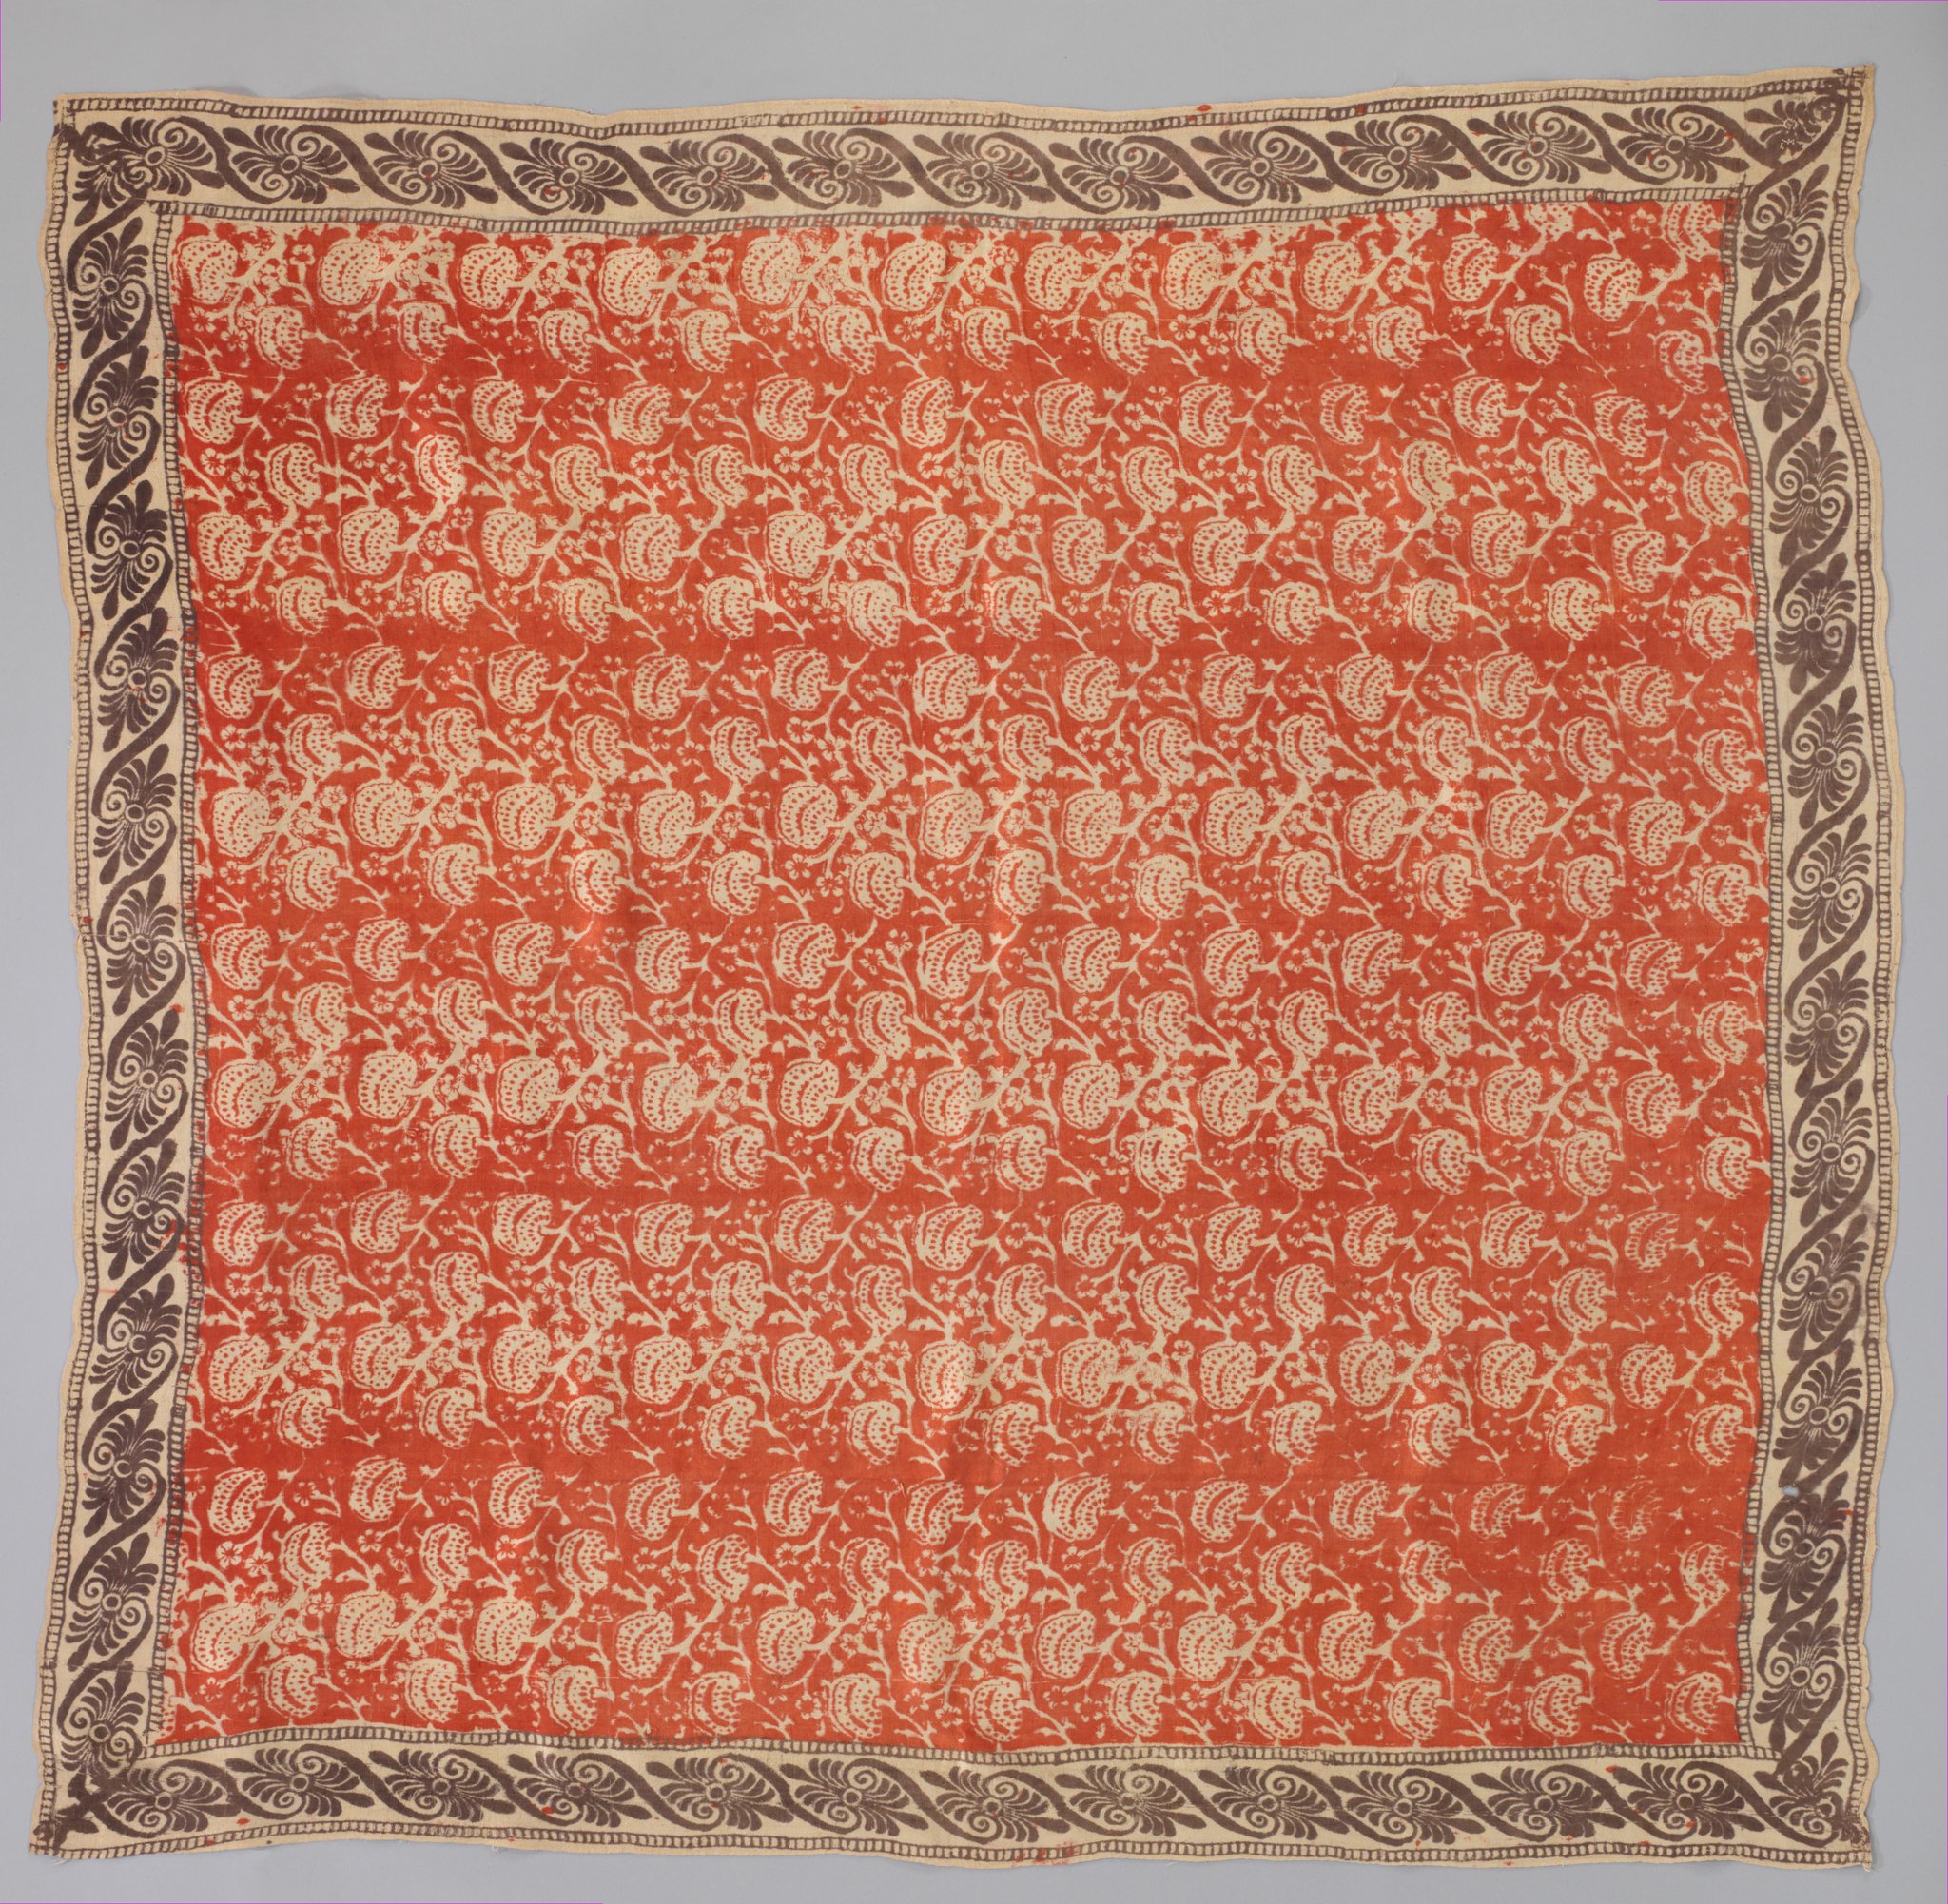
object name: handkerchief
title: Man's handkerchief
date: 1801-1900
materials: silk